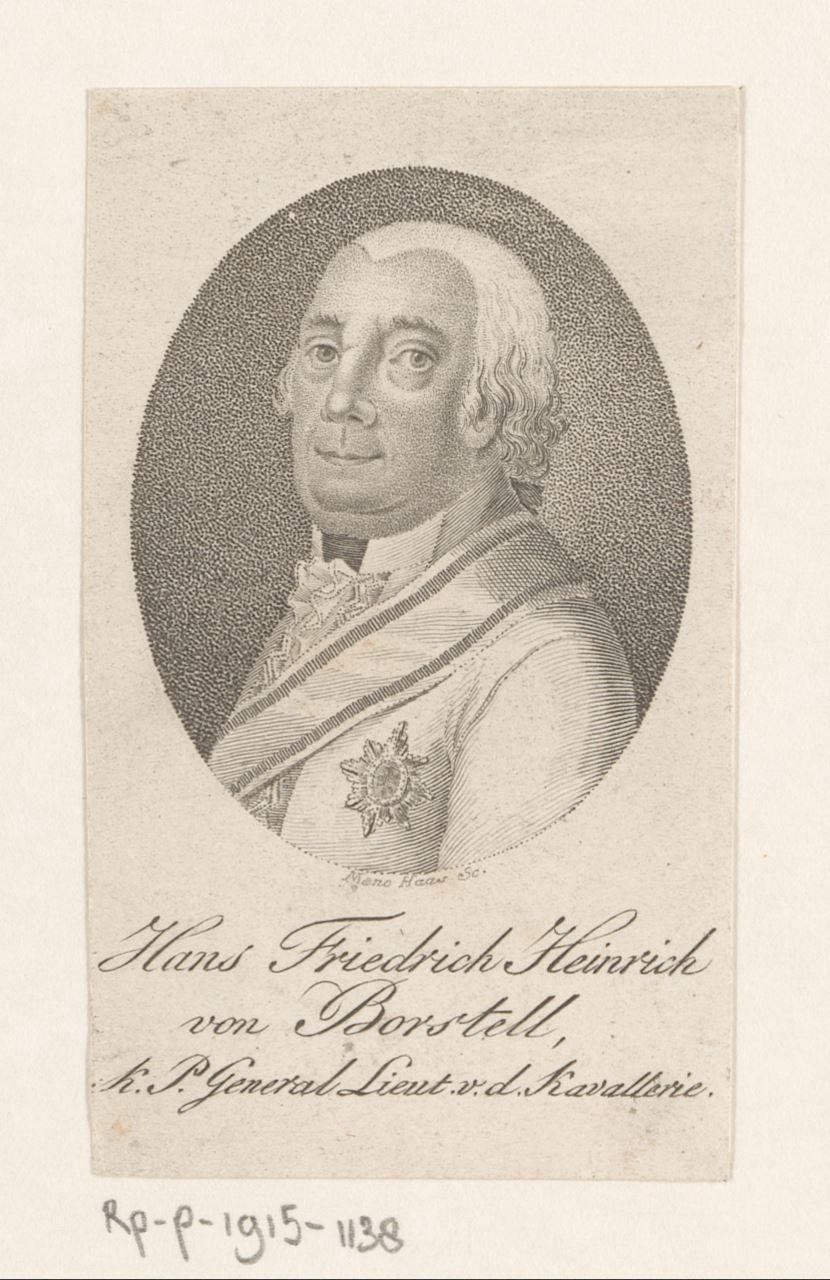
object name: print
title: Portret van Hans Friedrich Heinrich von Borstell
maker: meno haas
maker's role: print maker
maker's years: 1752-1833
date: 1762-1804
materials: paper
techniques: etching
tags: knighthood order, historical persons